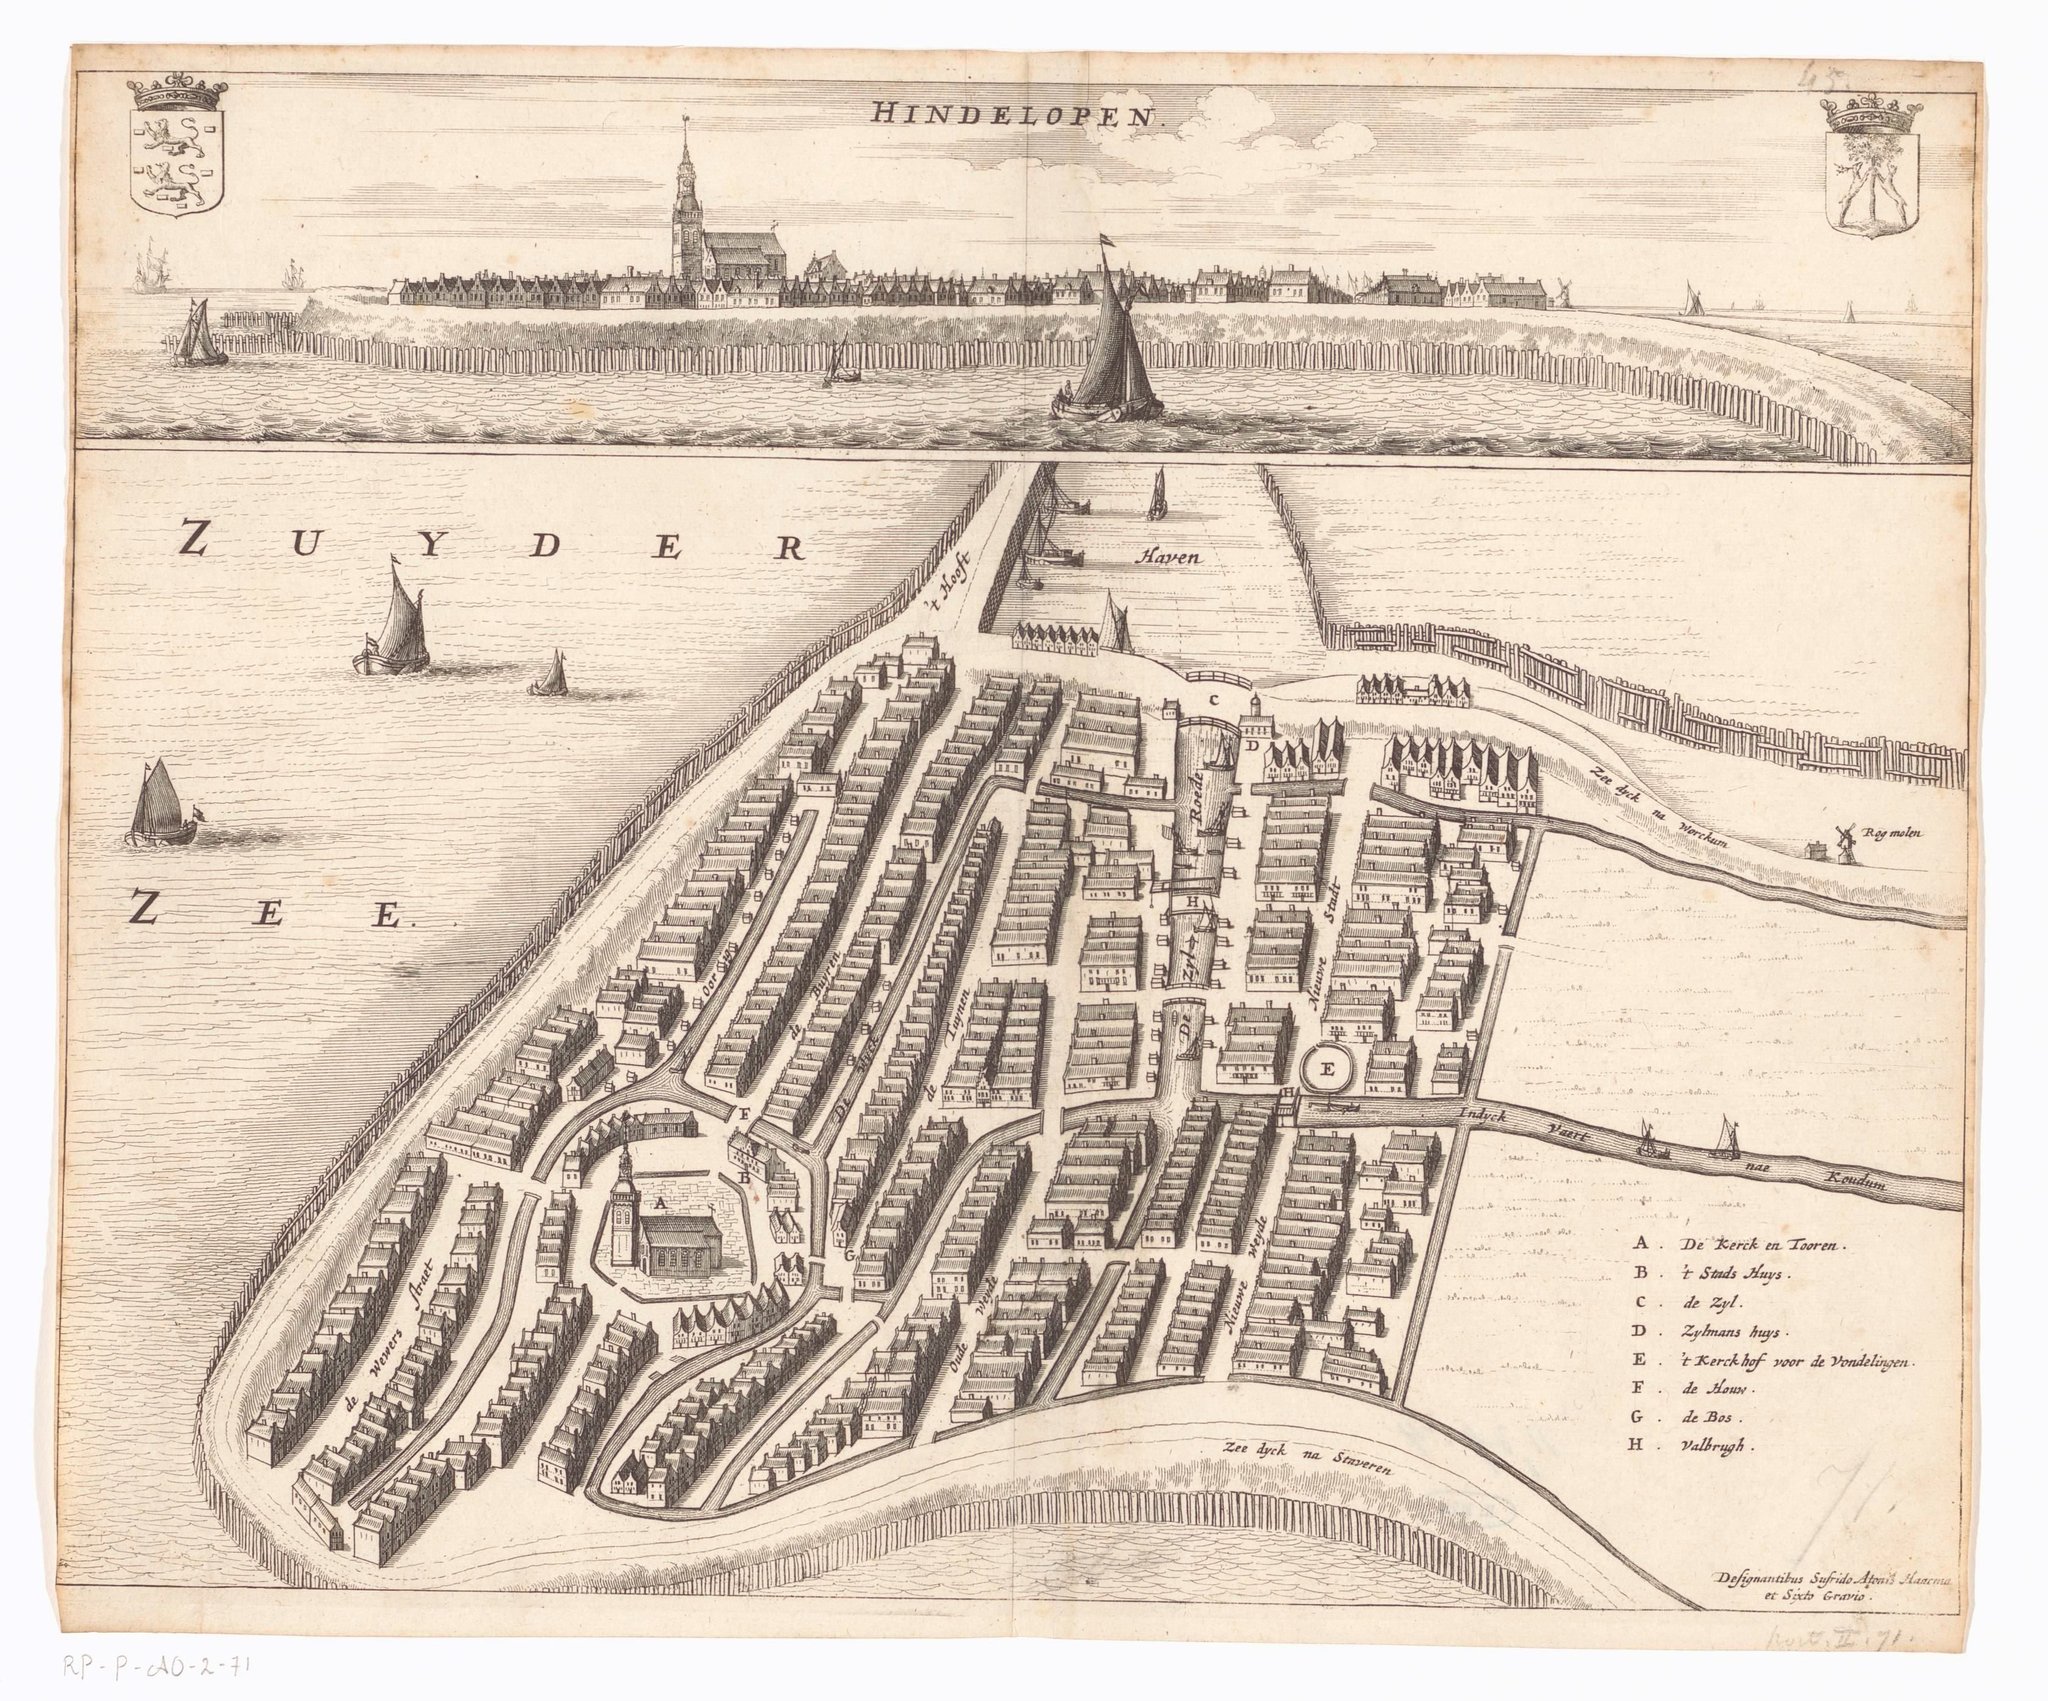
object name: print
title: Hindelopen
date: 1664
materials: paper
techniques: engraving, etching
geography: friesland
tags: coat of arms (as symbol of the state, etc.), city-view, and landscape with man-made constructions, maps of cities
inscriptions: collector's mark: Lugt 2228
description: Bovenaan een stadsgezicht van Hindeloopen met daarop links het wapen van Friesland en rechts dat van Hindeloopen. Daaronder een plattegrond van de stad in vogelvluchtperspectief. Rechtsonder legenda.